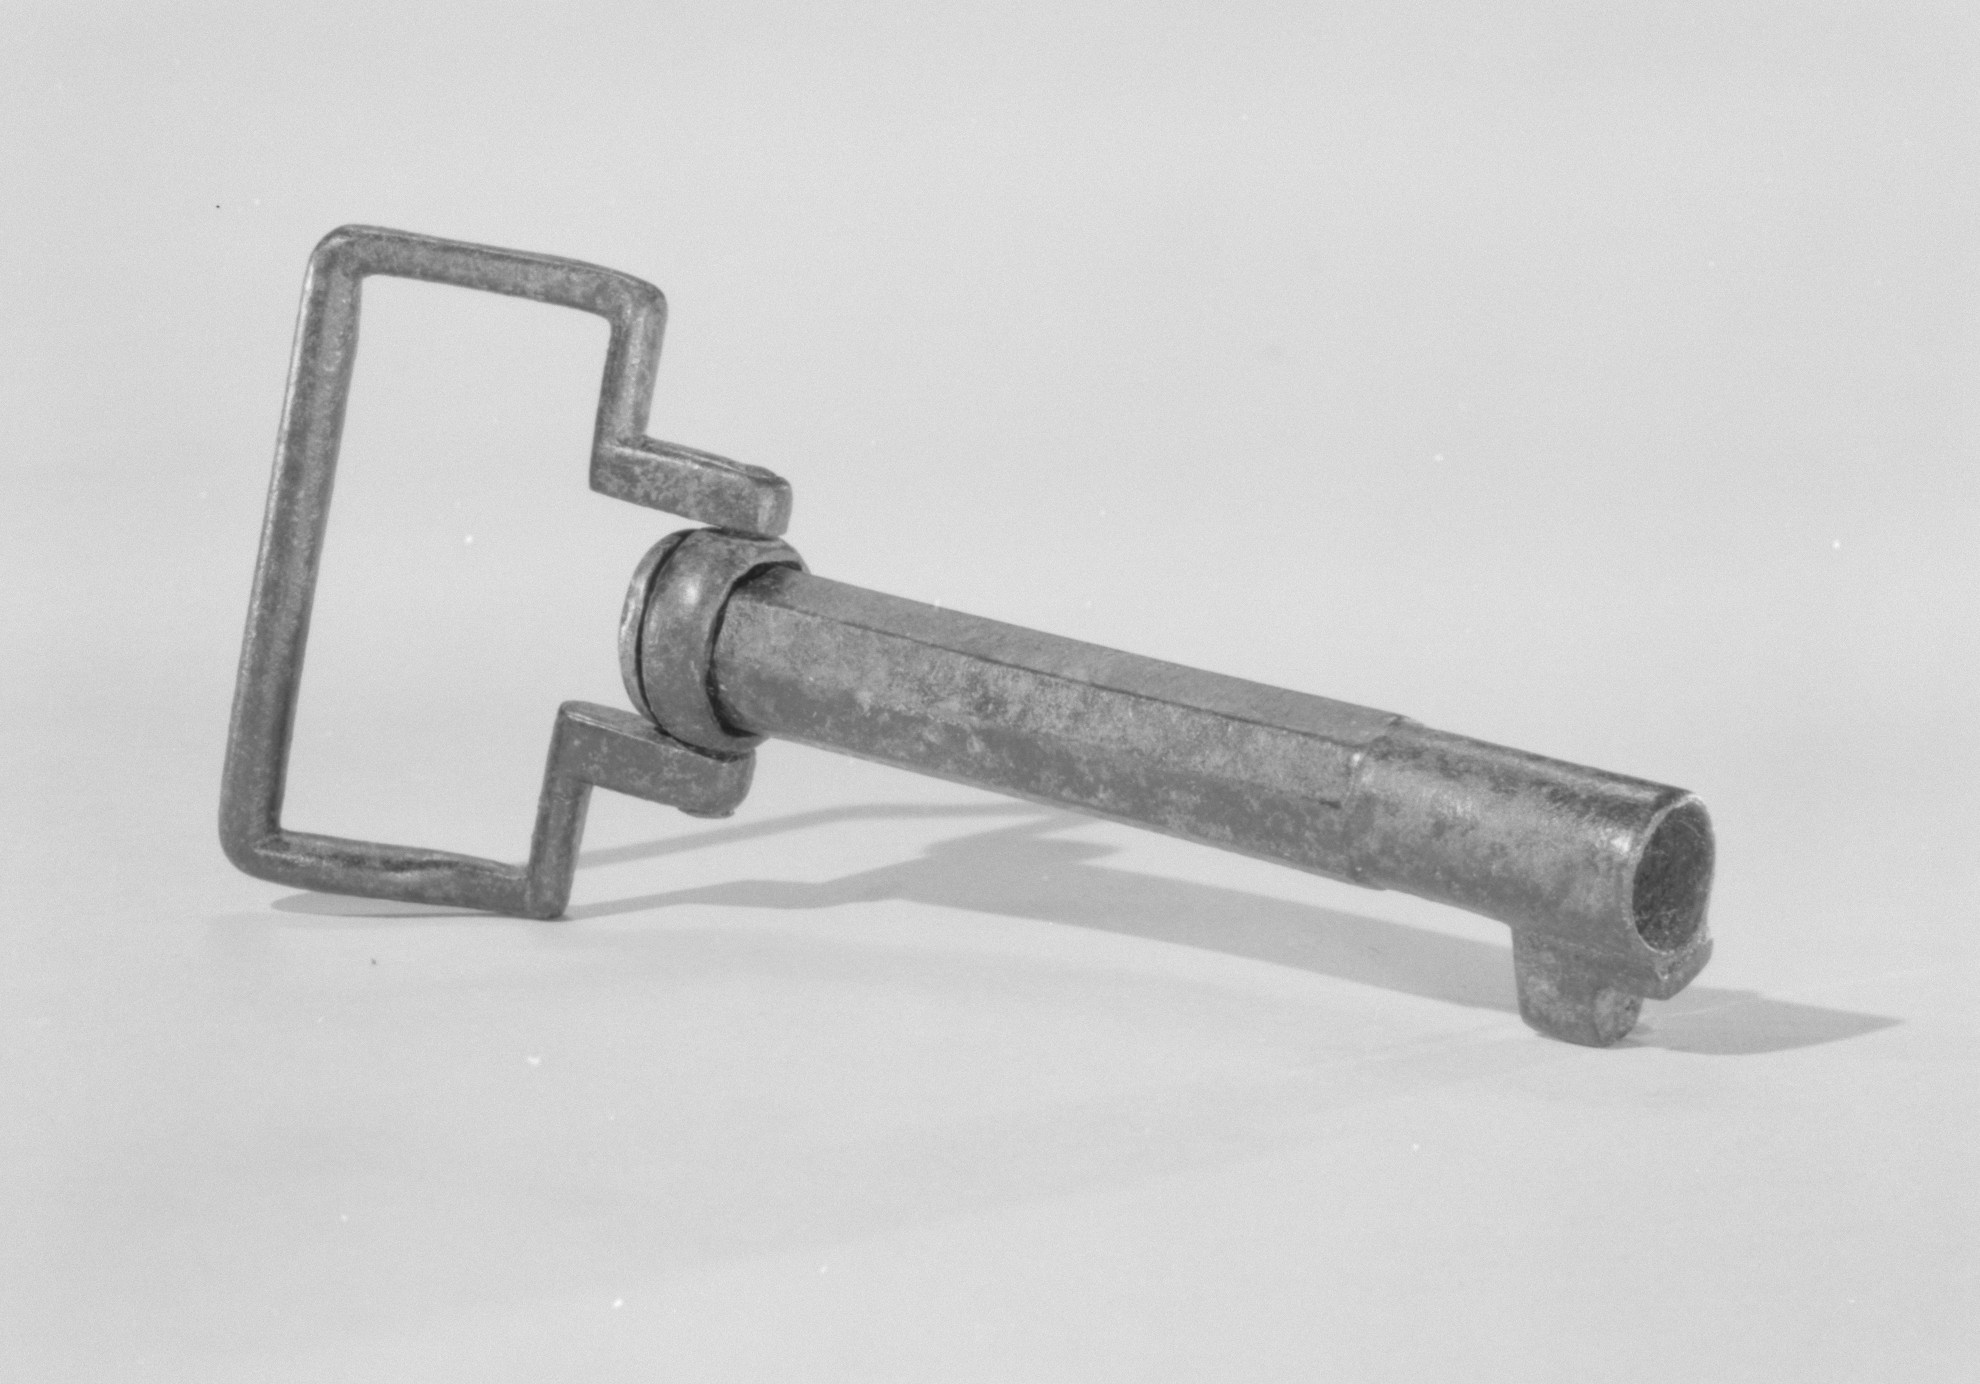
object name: coffer or chest key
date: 1601-1800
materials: iron